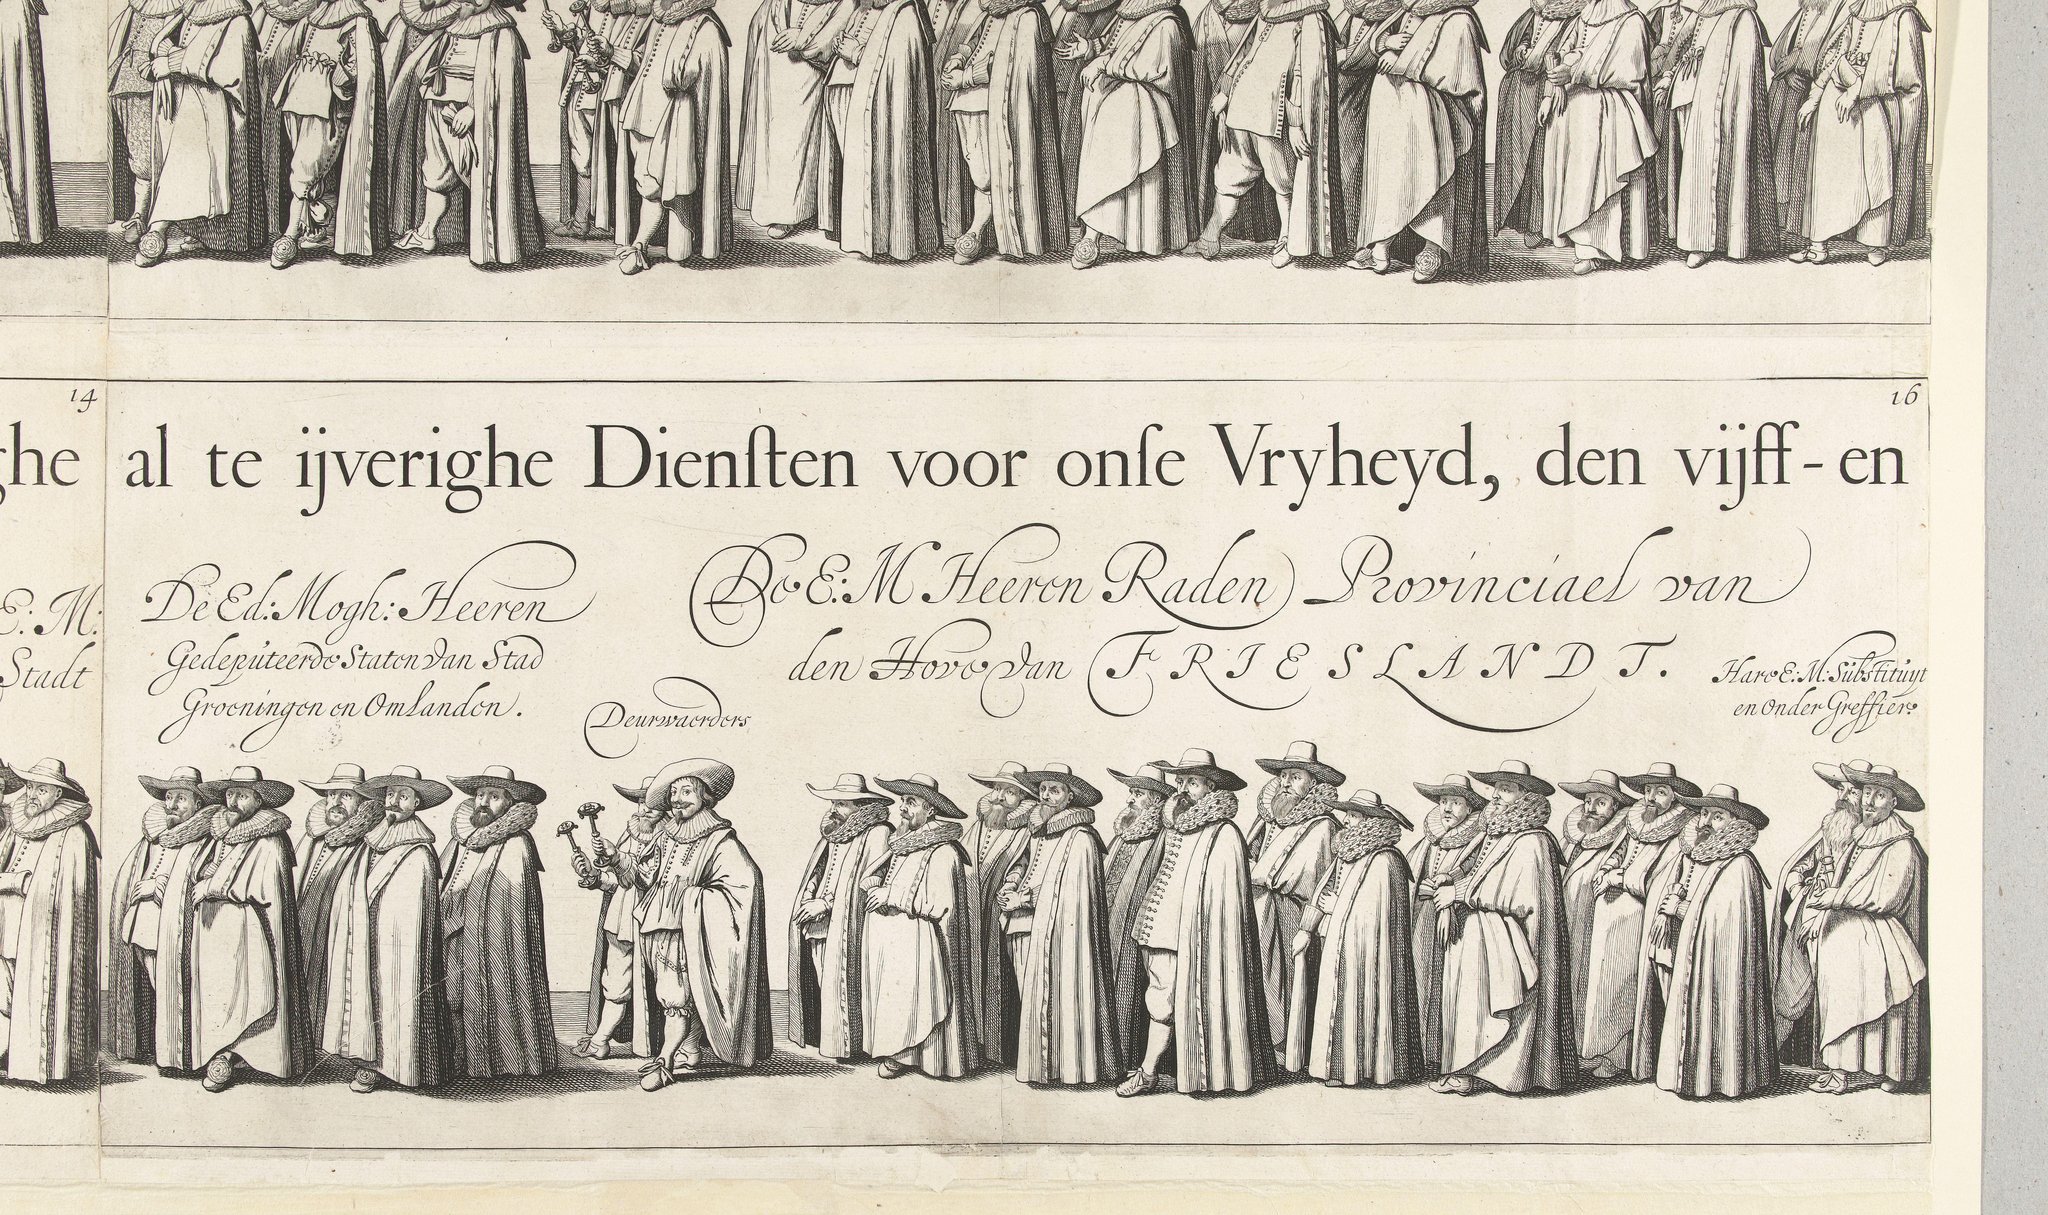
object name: print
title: Treur-Statighe Uyt-Vaert, ofte Begraeffenisse des ont-zielden Lichaems, van den On-vertsaeghden, ende seer Strijdtbaren Krijghs-Heldt, Ernest Casimyr (...) Overleden in de Belegheringhe voor Roermunde, door een Vyandtlijcke Koeghel (...) den vijff-en-twintichsten Maij, MDCXXXII. Begraven binnen Leeuwarden in 't Choor van de Iacobijner Kercke, den derden Ianuarij, MDCXXXIII. Oude Stijl.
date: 1634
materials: paper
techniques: engraving, etching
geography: northern netherlands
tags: ernst casimir graaf van nassau-dietz, cortege, funeral procession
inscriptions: date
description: Deel van de begrafenisstoet met leden van het Hof van Friesland. Bovenin de functies van de afgebeelde personen. Plaat nr. 16 in de prentserie van de begrafenis van Ernst Casimir, graaf van Nassau-Dietz te Leeuwarden, 3 januari 1633. De wapens en vaandels zijn ingekleurd. Dit blad samen met bladen 13, 14 en 15 aan elkaar geplakt.